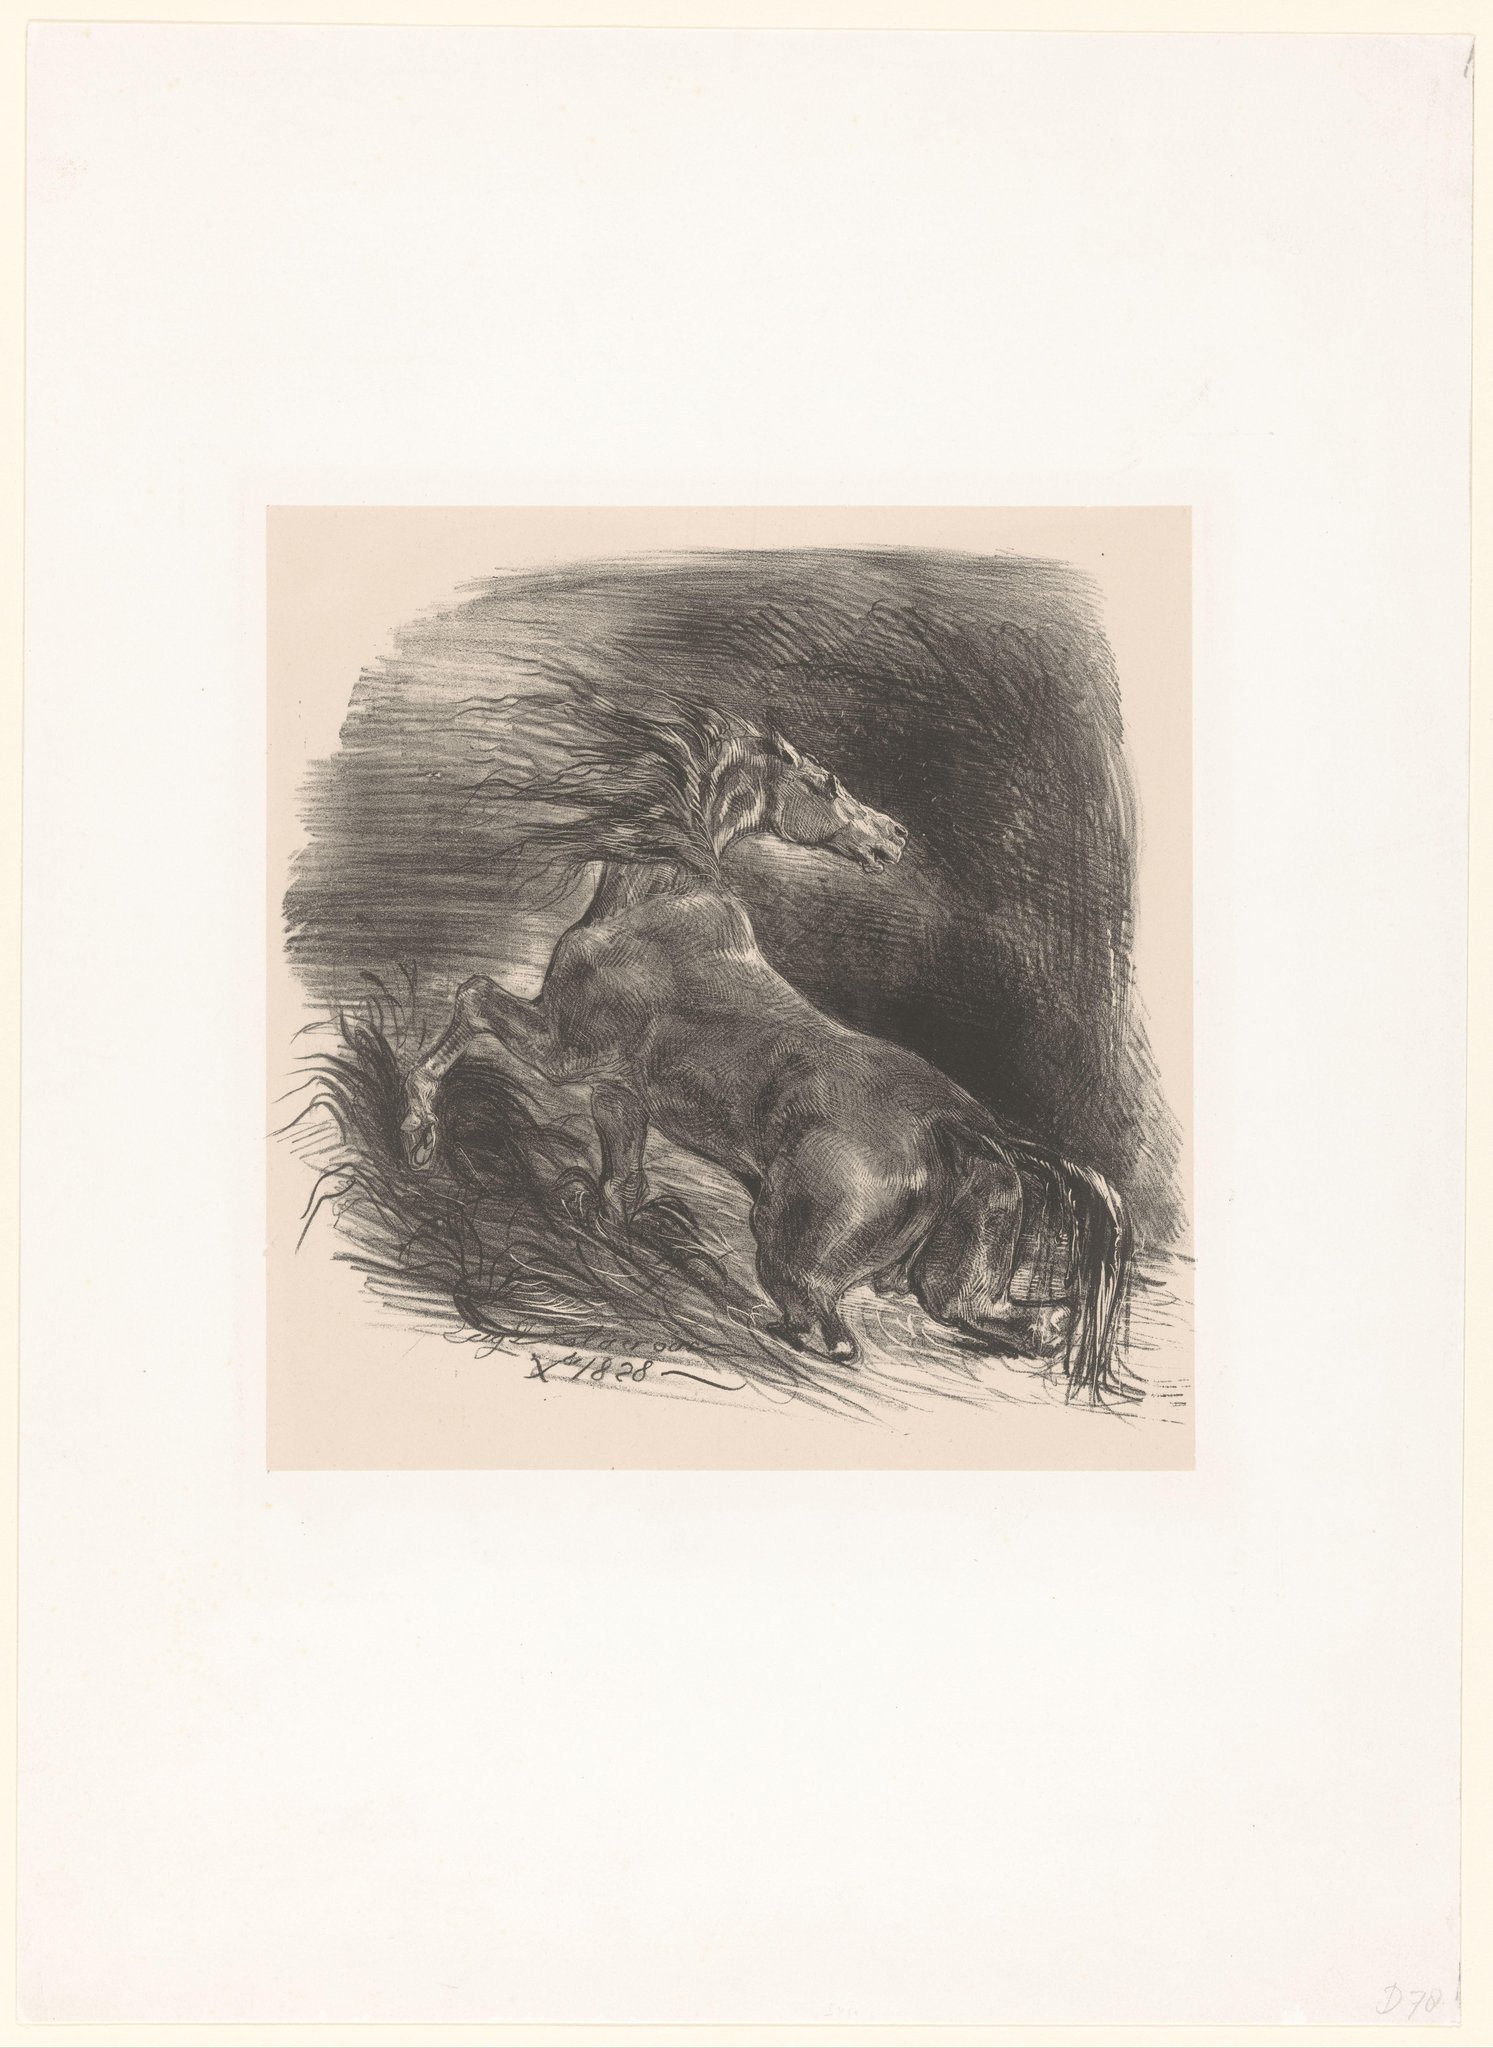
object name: print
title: Wild paard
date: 1828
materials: paper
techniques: lithograph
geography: paris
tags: horse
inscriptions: collector's mark: Lugt 2228a, collector's mark: Lugt 2760